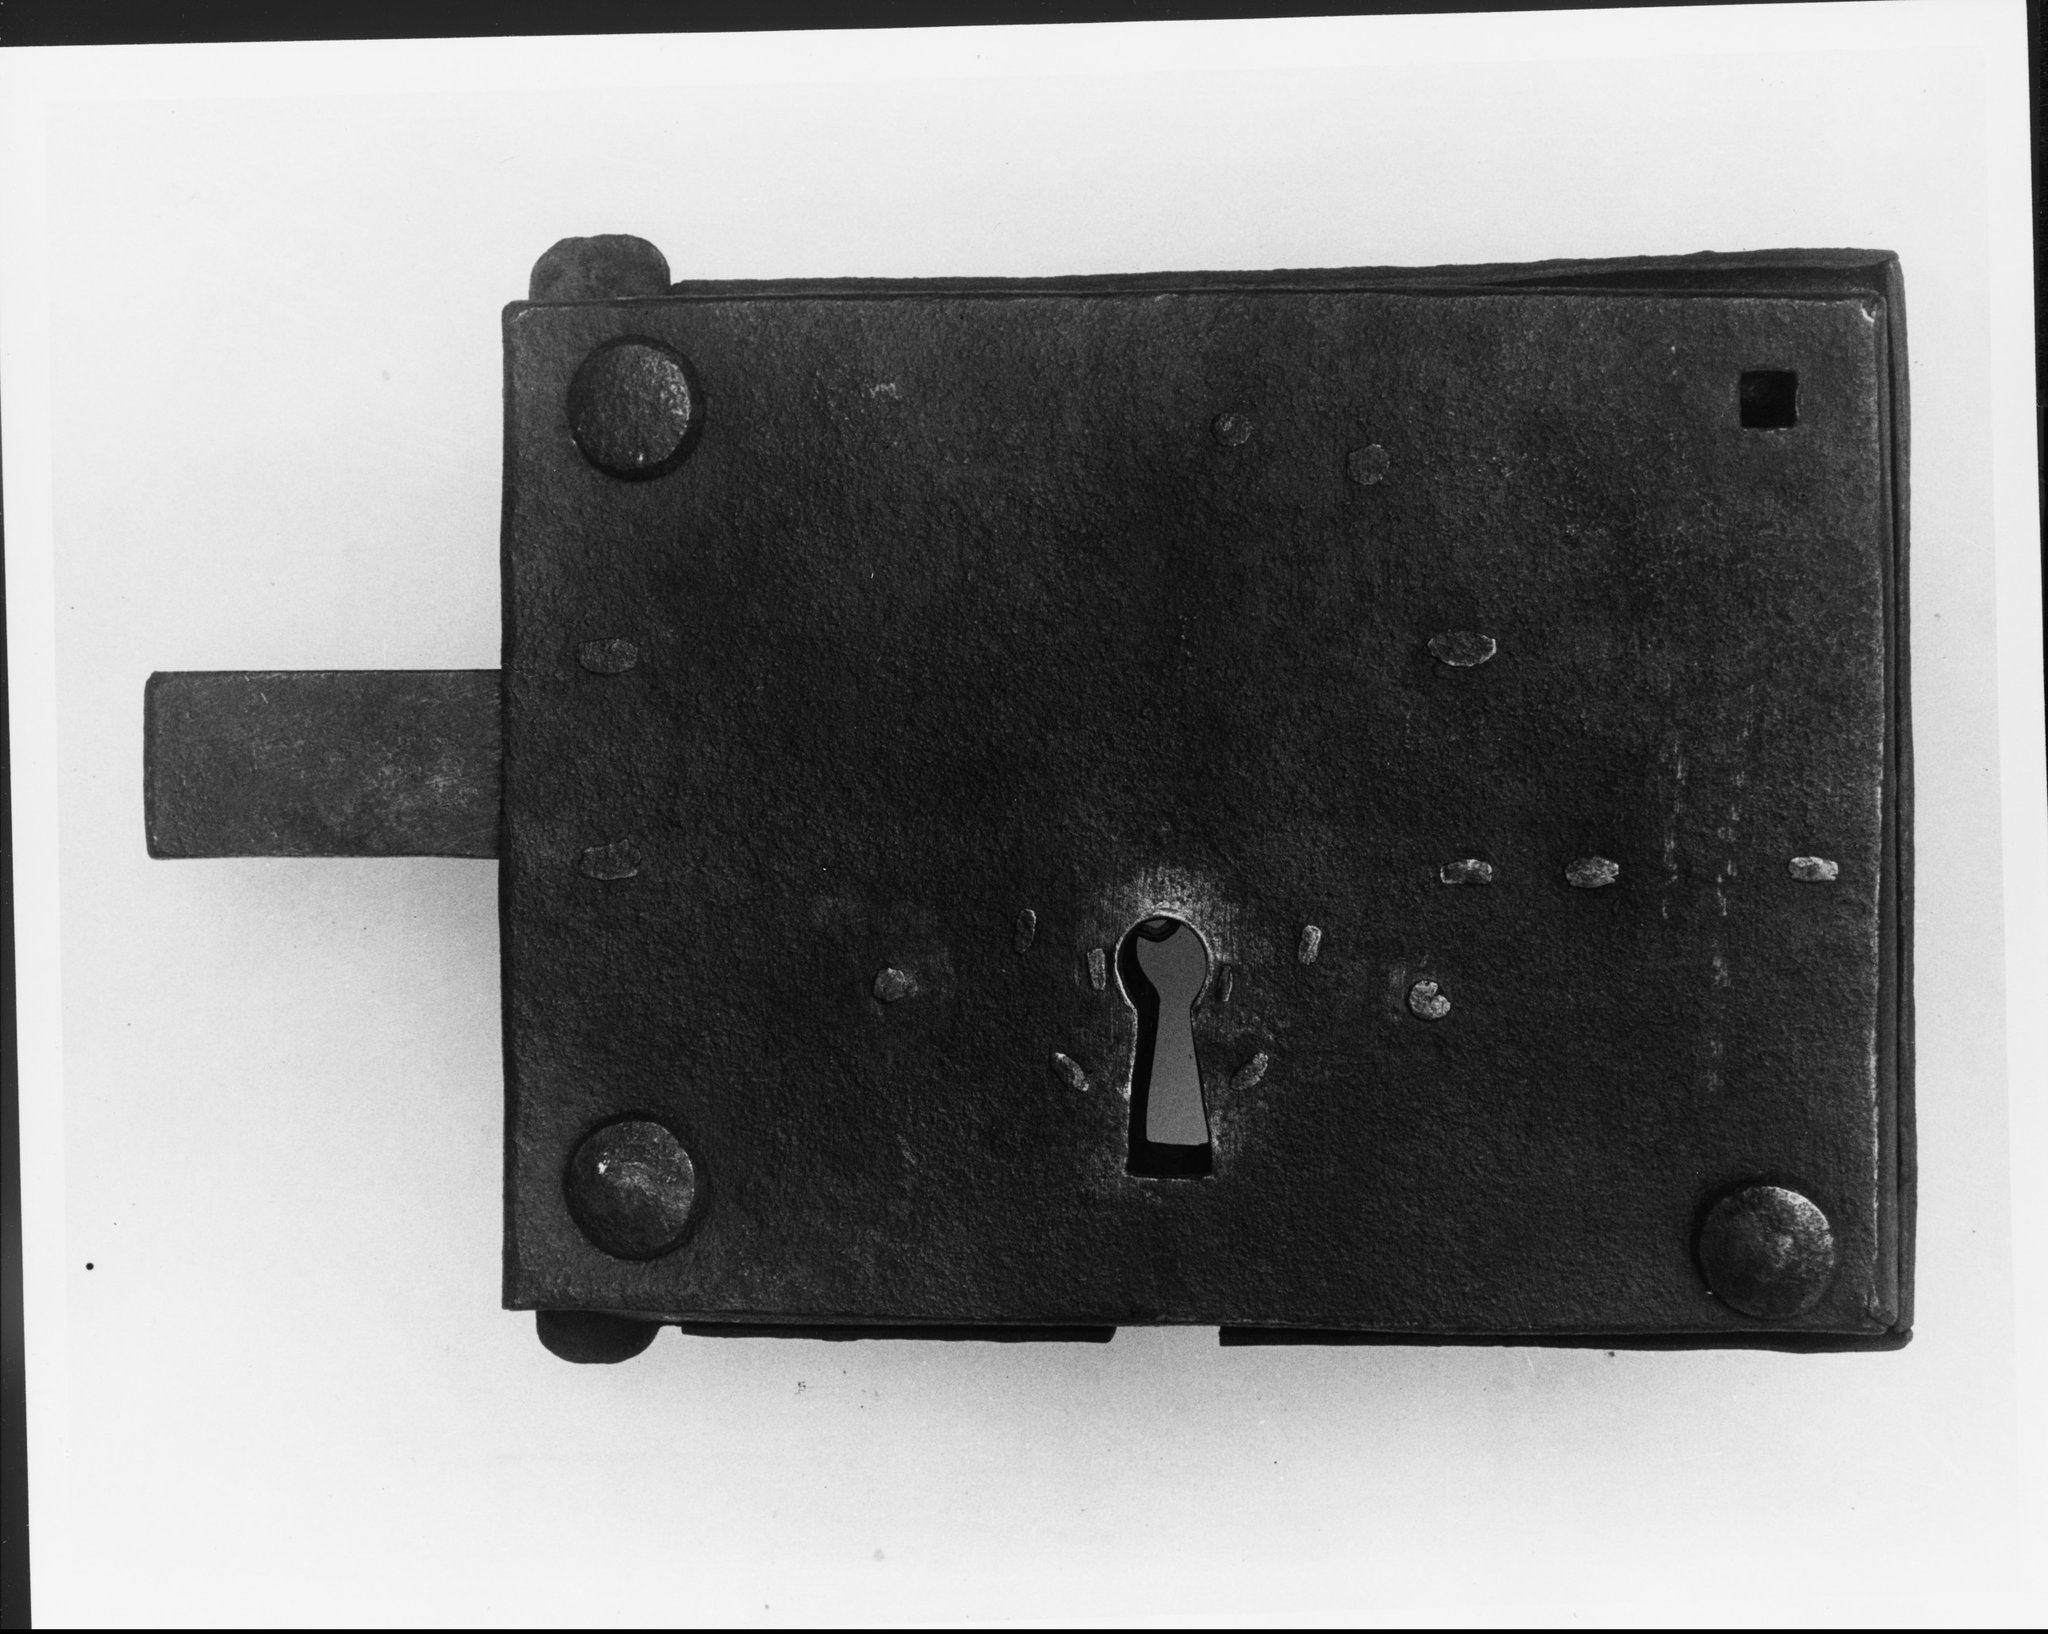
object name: lock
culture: american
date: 1700-1800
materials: iron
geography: united states